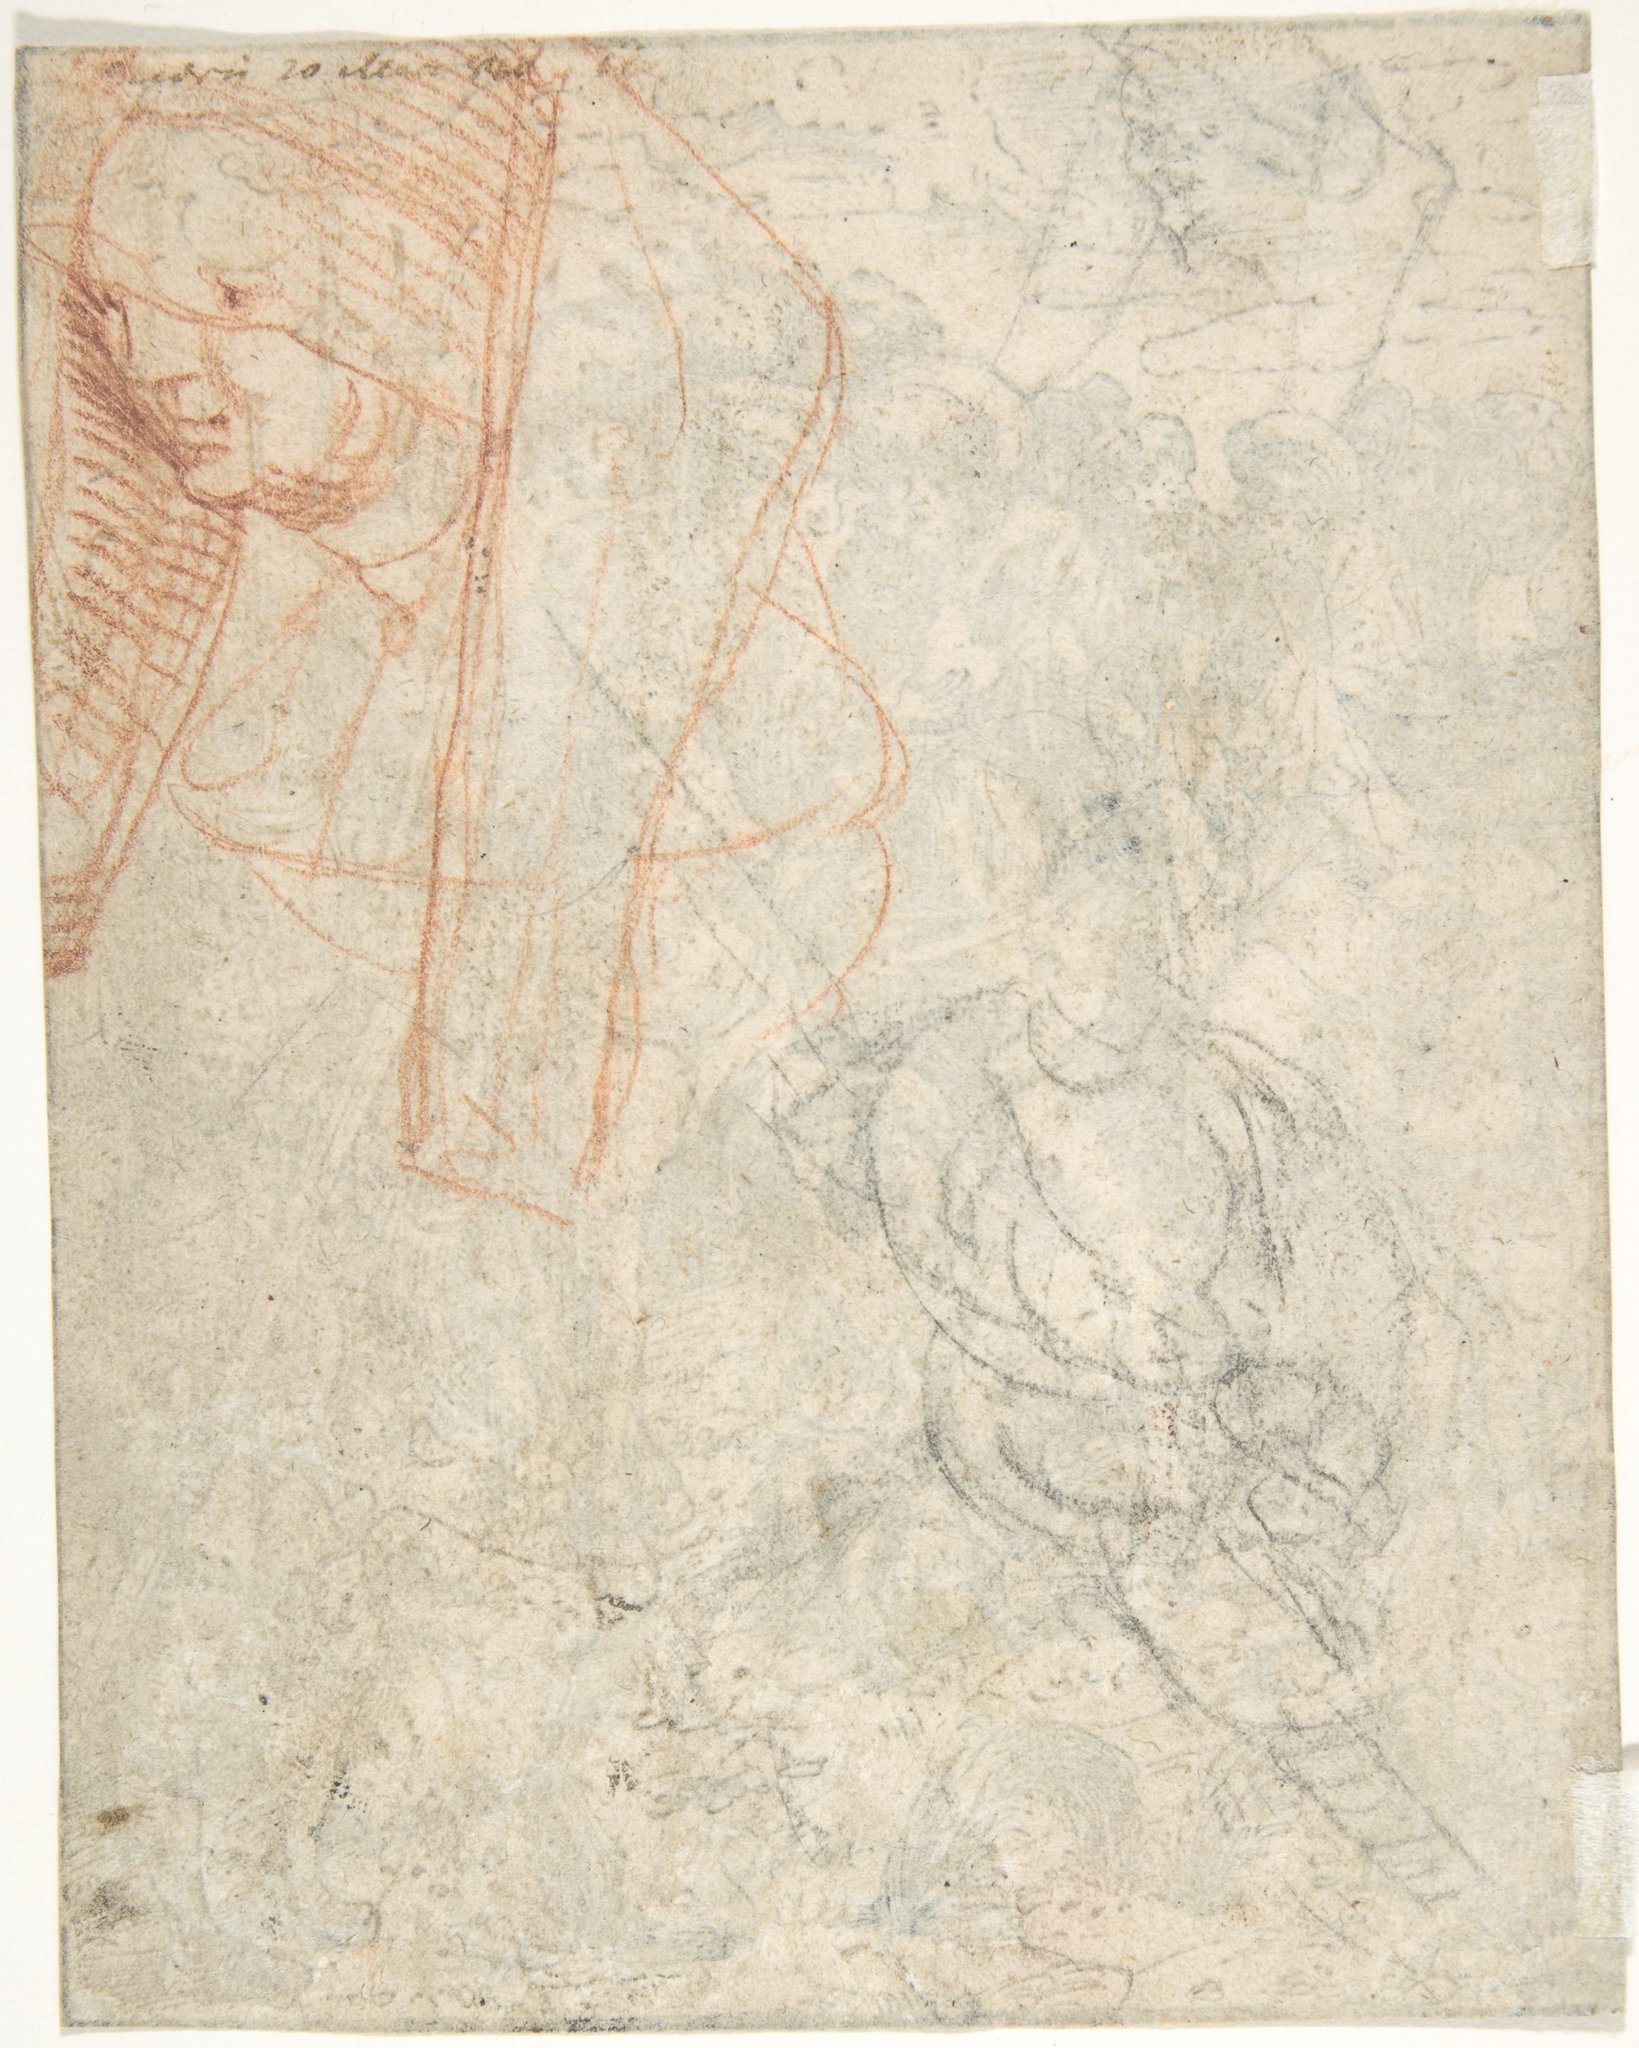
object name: drawing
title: Head of a Woman and Sketch of a Figure (?)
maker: anonymous, german, 16th century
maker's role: artist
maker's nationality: german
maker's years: 1500-1600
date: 1501-1600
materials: chalk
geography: germany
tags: heads,women